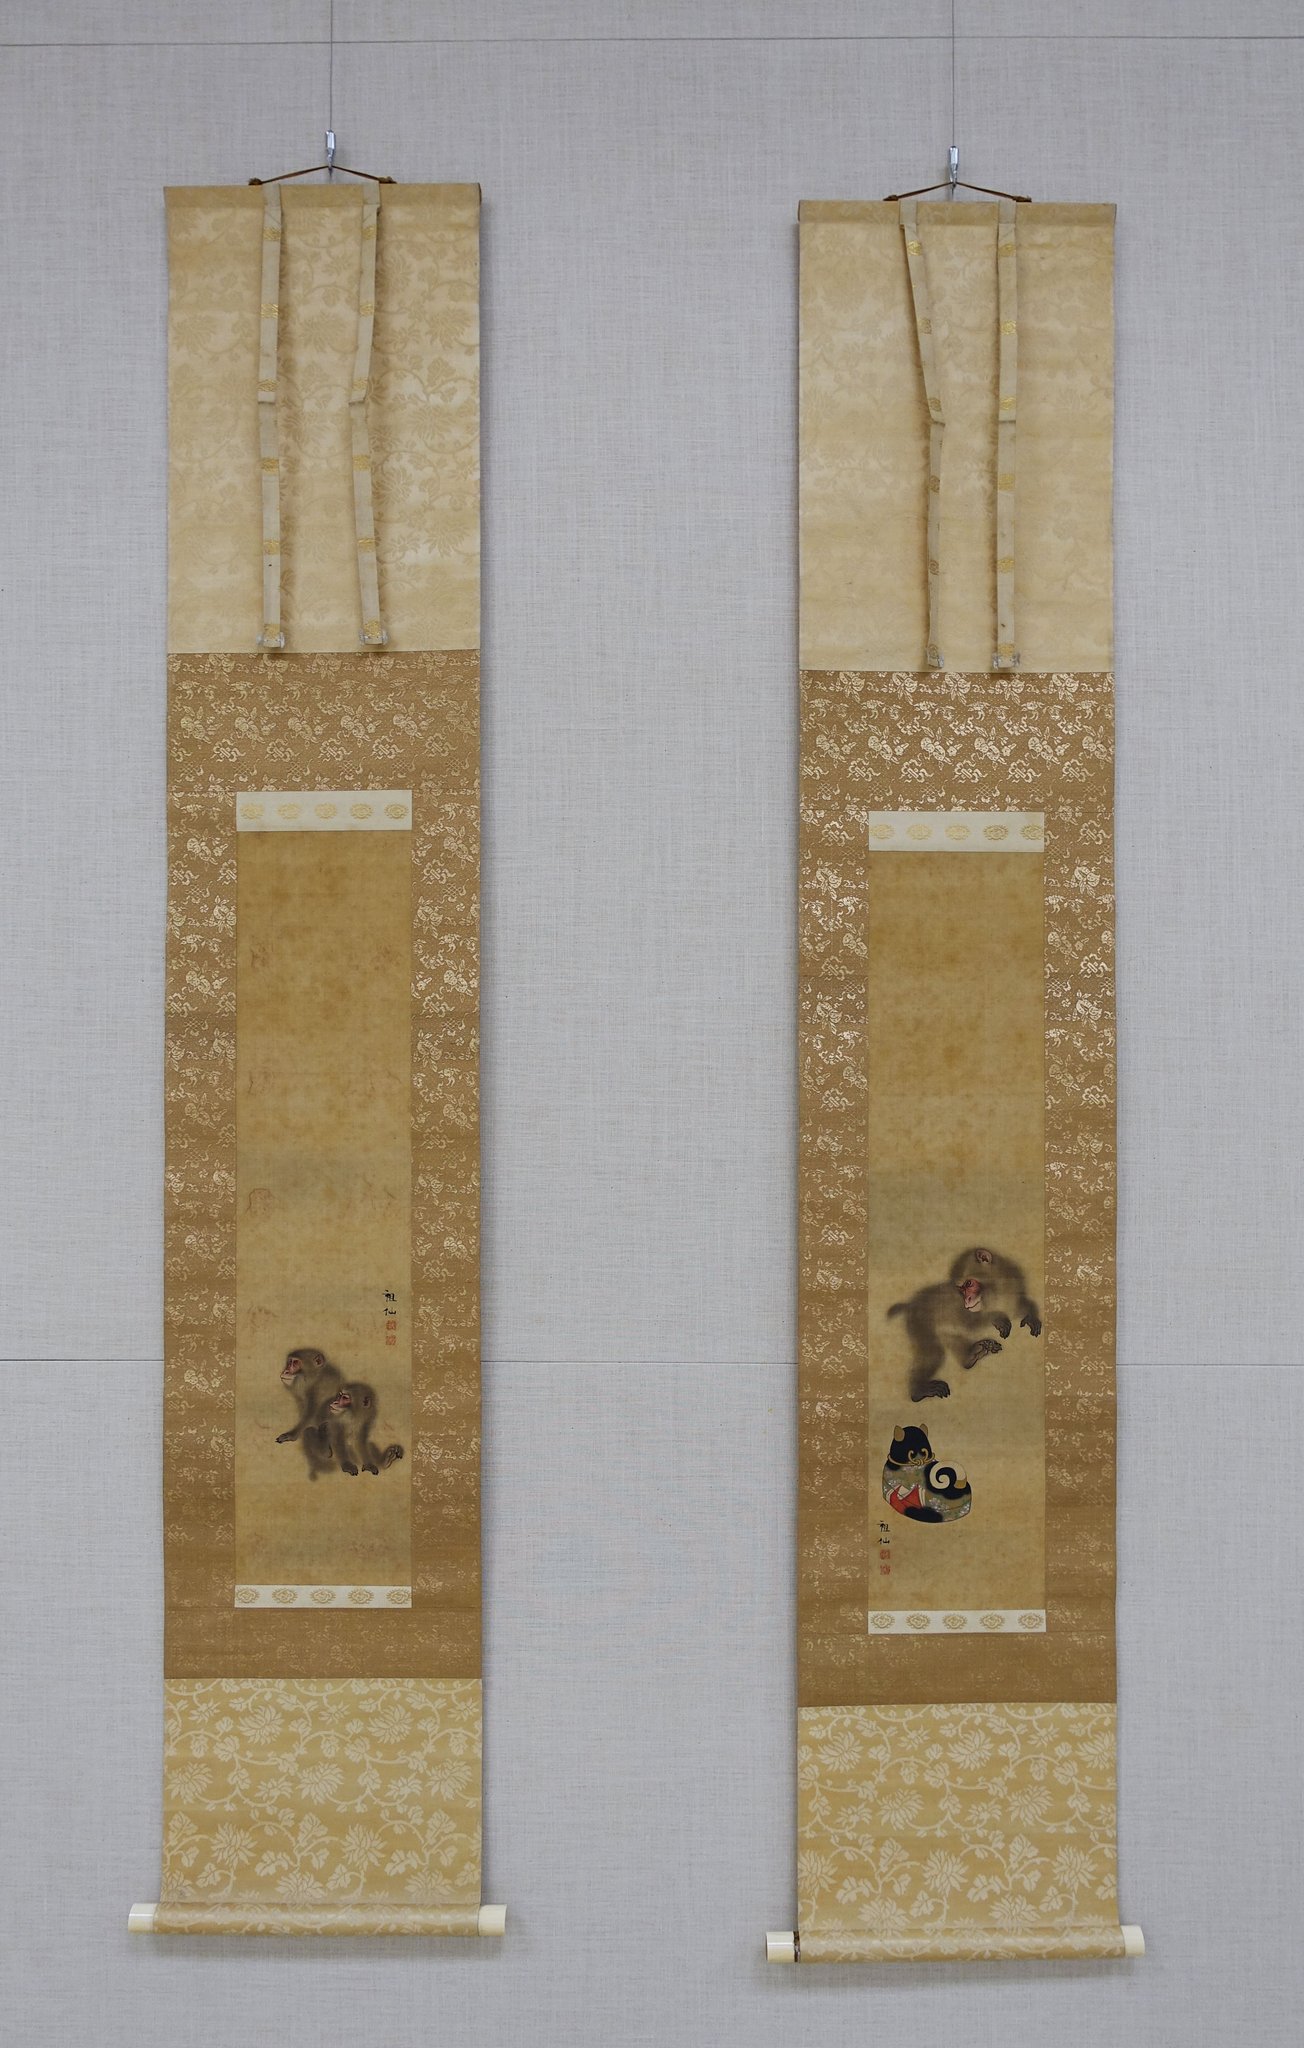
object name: hanging scroll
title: Monkeys at Play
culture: japanese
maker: mori sosen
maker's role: artist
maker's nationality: japanese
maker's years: 1747-1821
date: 1767-1800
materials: ink, silk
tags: monkeys